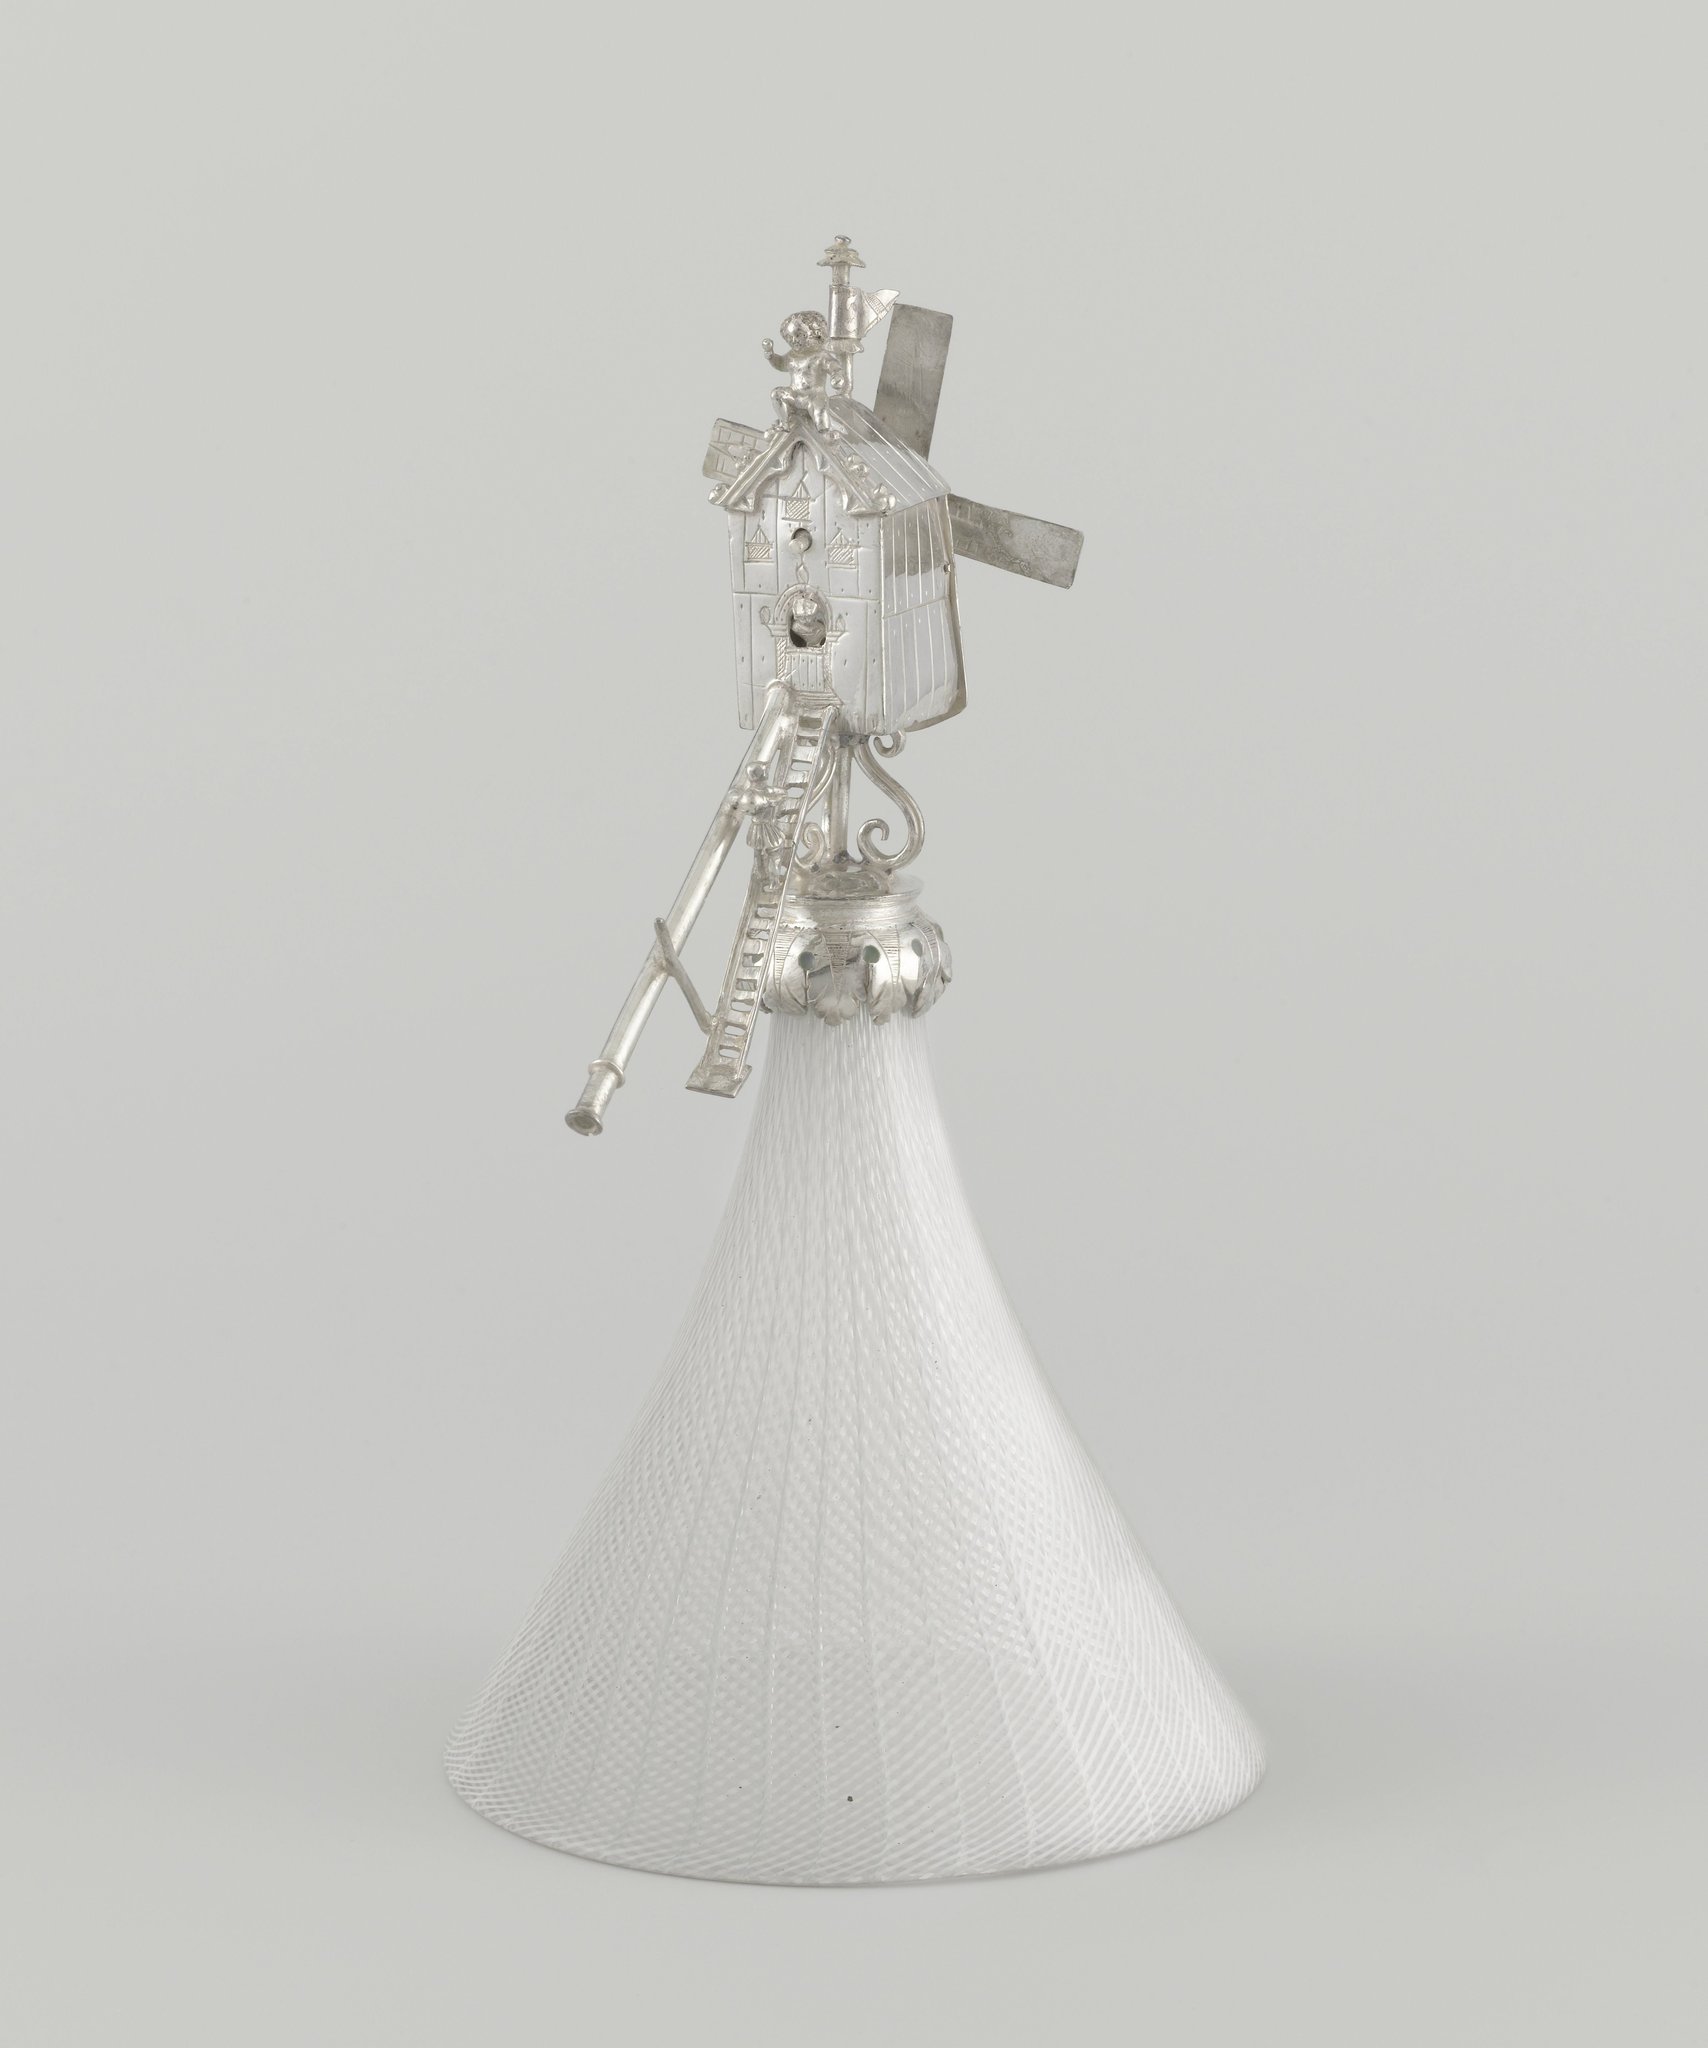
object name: molenbeker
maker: Anonymous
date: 1600-1700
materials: glass, silver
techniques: façon de venise, glassblowing, vetro a retorti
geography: low countries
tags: miller, ladder, windmill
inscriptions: mark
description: Mill glass, filigree glass and silver. Netherlands, façon de Venise, c. 1600-1700.